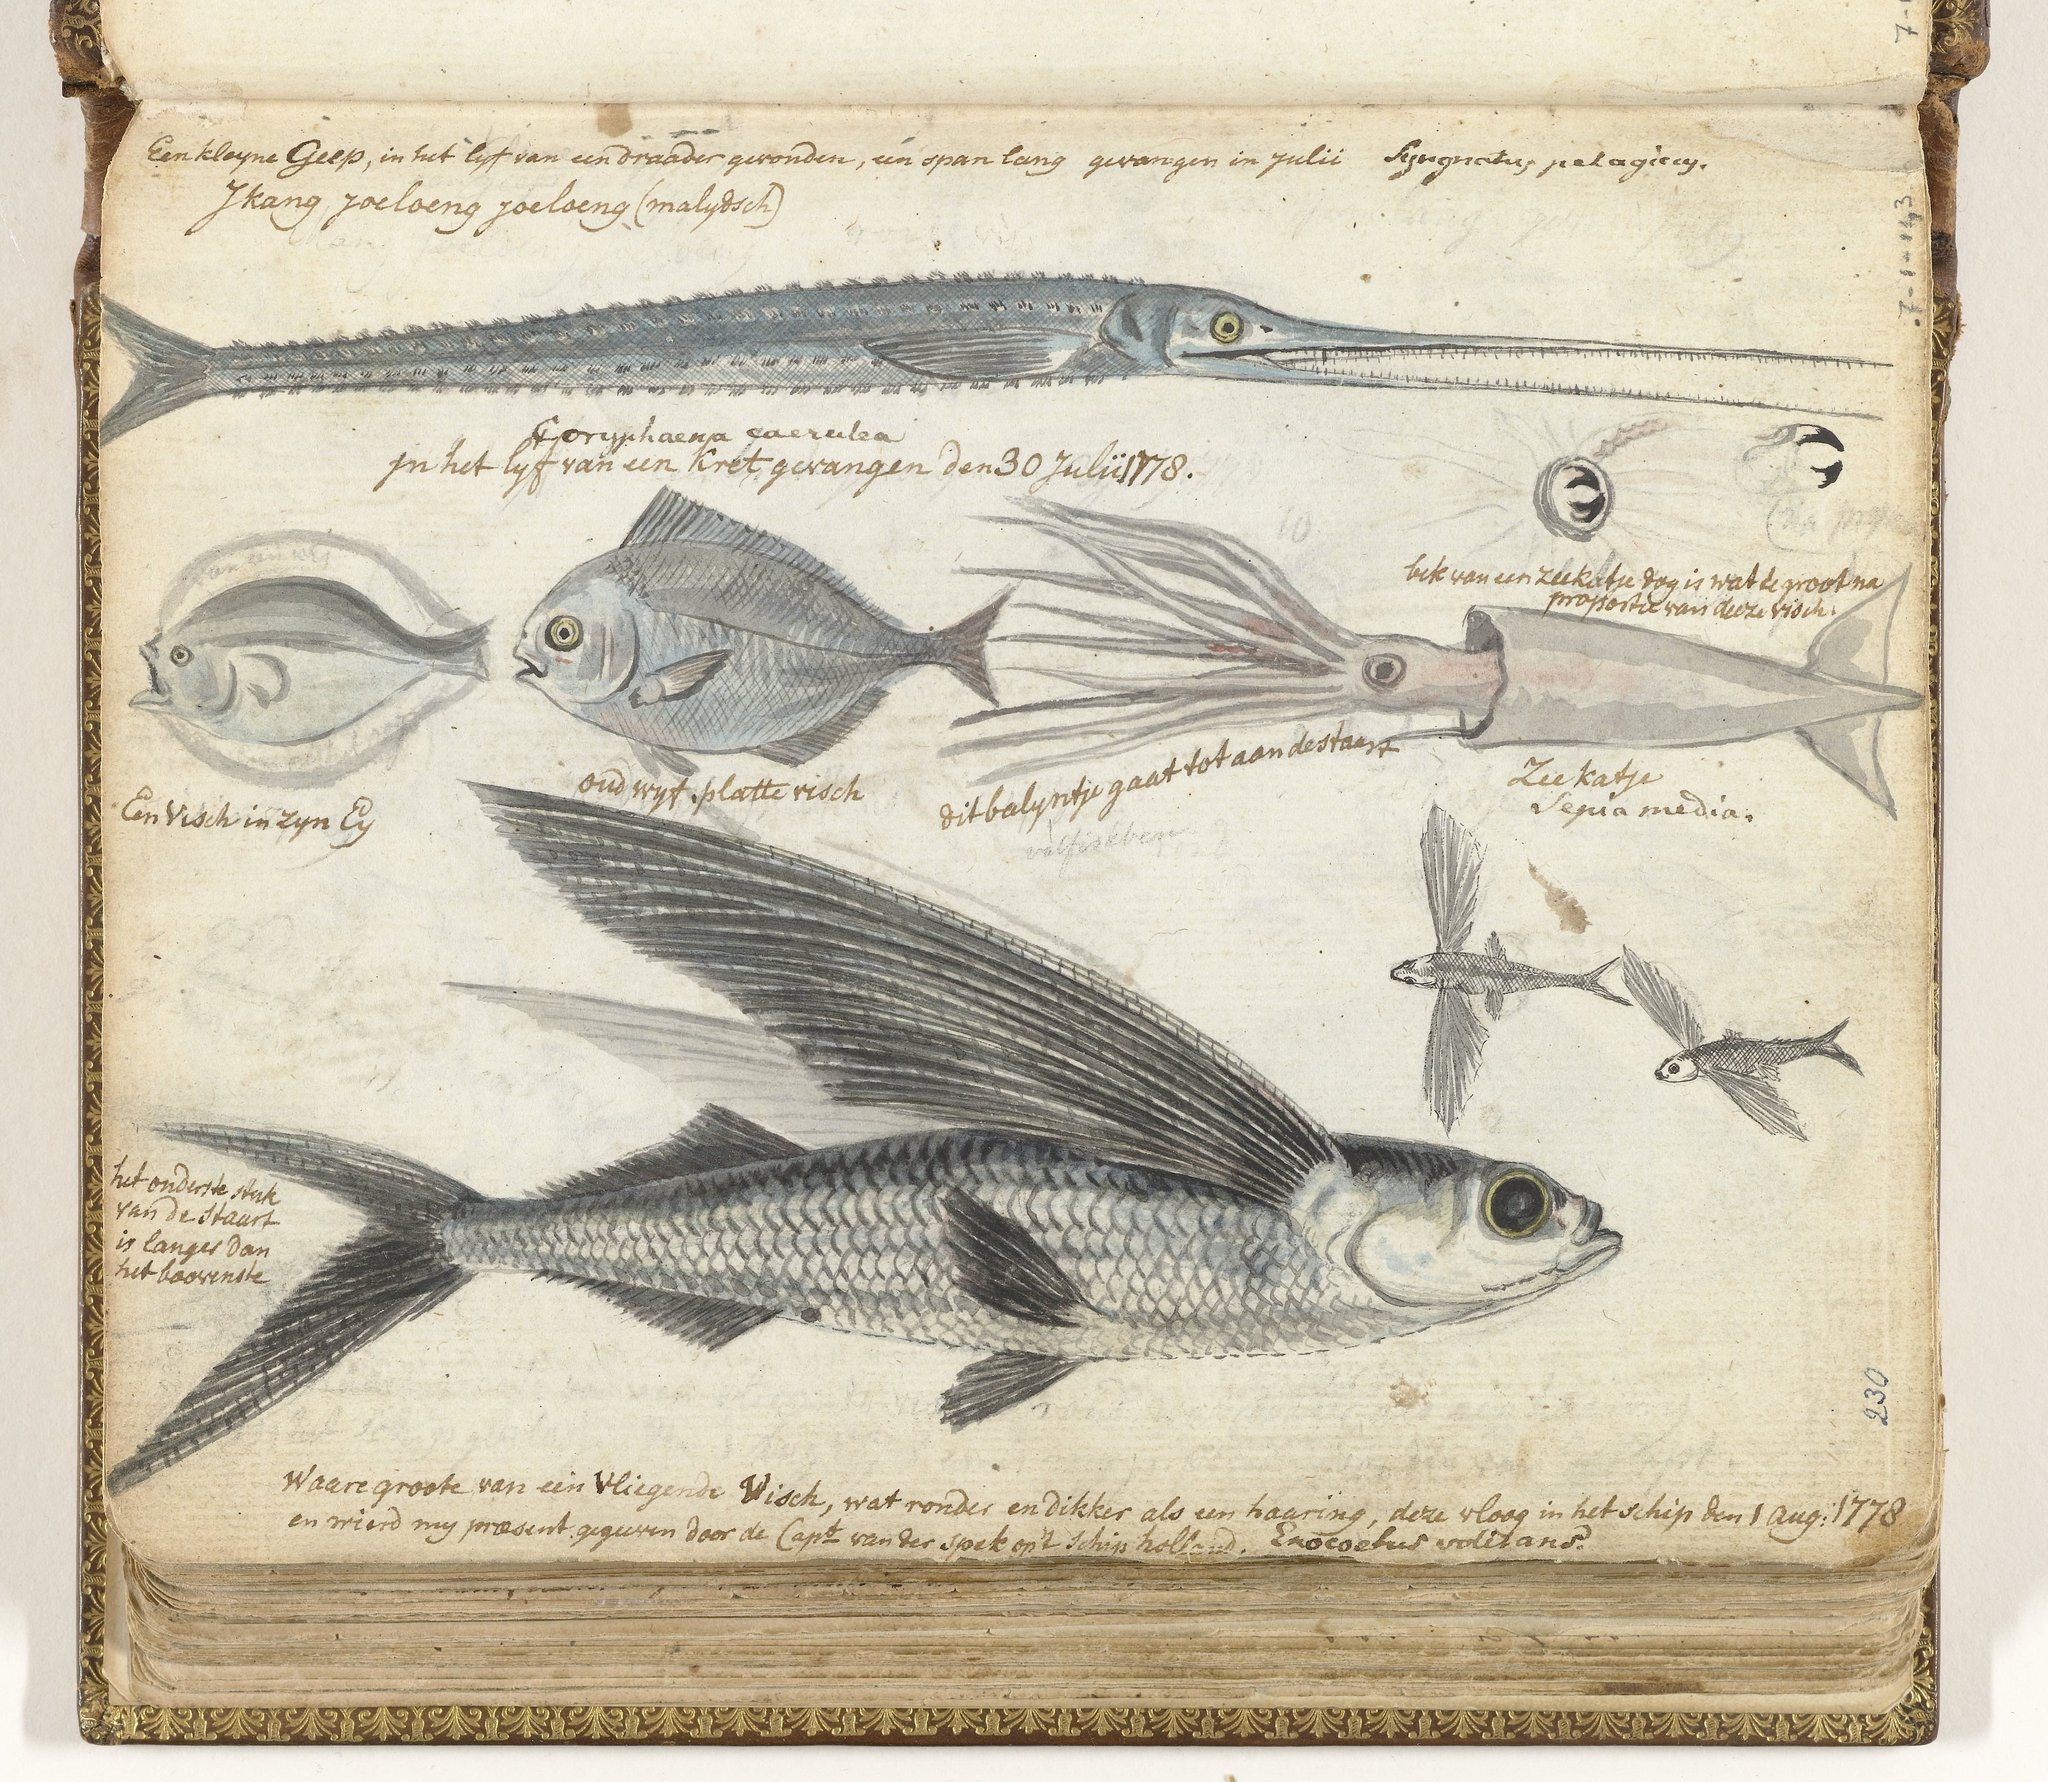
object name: drawing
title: Zeevissen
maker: jan brandes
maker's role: draughtsman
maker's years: 1743-1808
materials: paper, pencil, watercolor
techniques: brush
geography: atlantic ocean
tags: bony fishes: flying fish, molluscs: squid, bony fishes, atlantic ocean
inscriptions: inscription: ‘Een Visch in zyn Ey / oud wyf, platte visch / dit balyntje gaat tot aan destaart / bek van zeekatje ... is wat te groot na ...opositie van deeze visch / Zeekatje Sepia media’, inscription: ‘Een kleyne Geep, in het lyf van een draader gevonden, een span lang gevangen in julii. Syngnatus pelagicus Ikang joeloeng joeloeng (malydsch)’, inscription: ‘het onderste stuk van de staart is langer dan het boovenste / waare groote van een Vliegende Visch, wat ronder en dikker als een haaring, deze vloog in het schip den 1 aug. 1778 en wierd my present gegeeven door Capt van der Spek op 't schip Holland. Exocoetus volitans.’, inscription: ‘Coryphaena caerulea ini het lyf van een Kret gevangen, den 30 Julii 1778.’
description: Kleurtekeningen van een viertal vissen, geep, platvis, zeekatje en vliegende vis. Met opschriften. Onderdeel uit het schetsboek van Jan Brandes, dl. 1 (1808), p. 230.